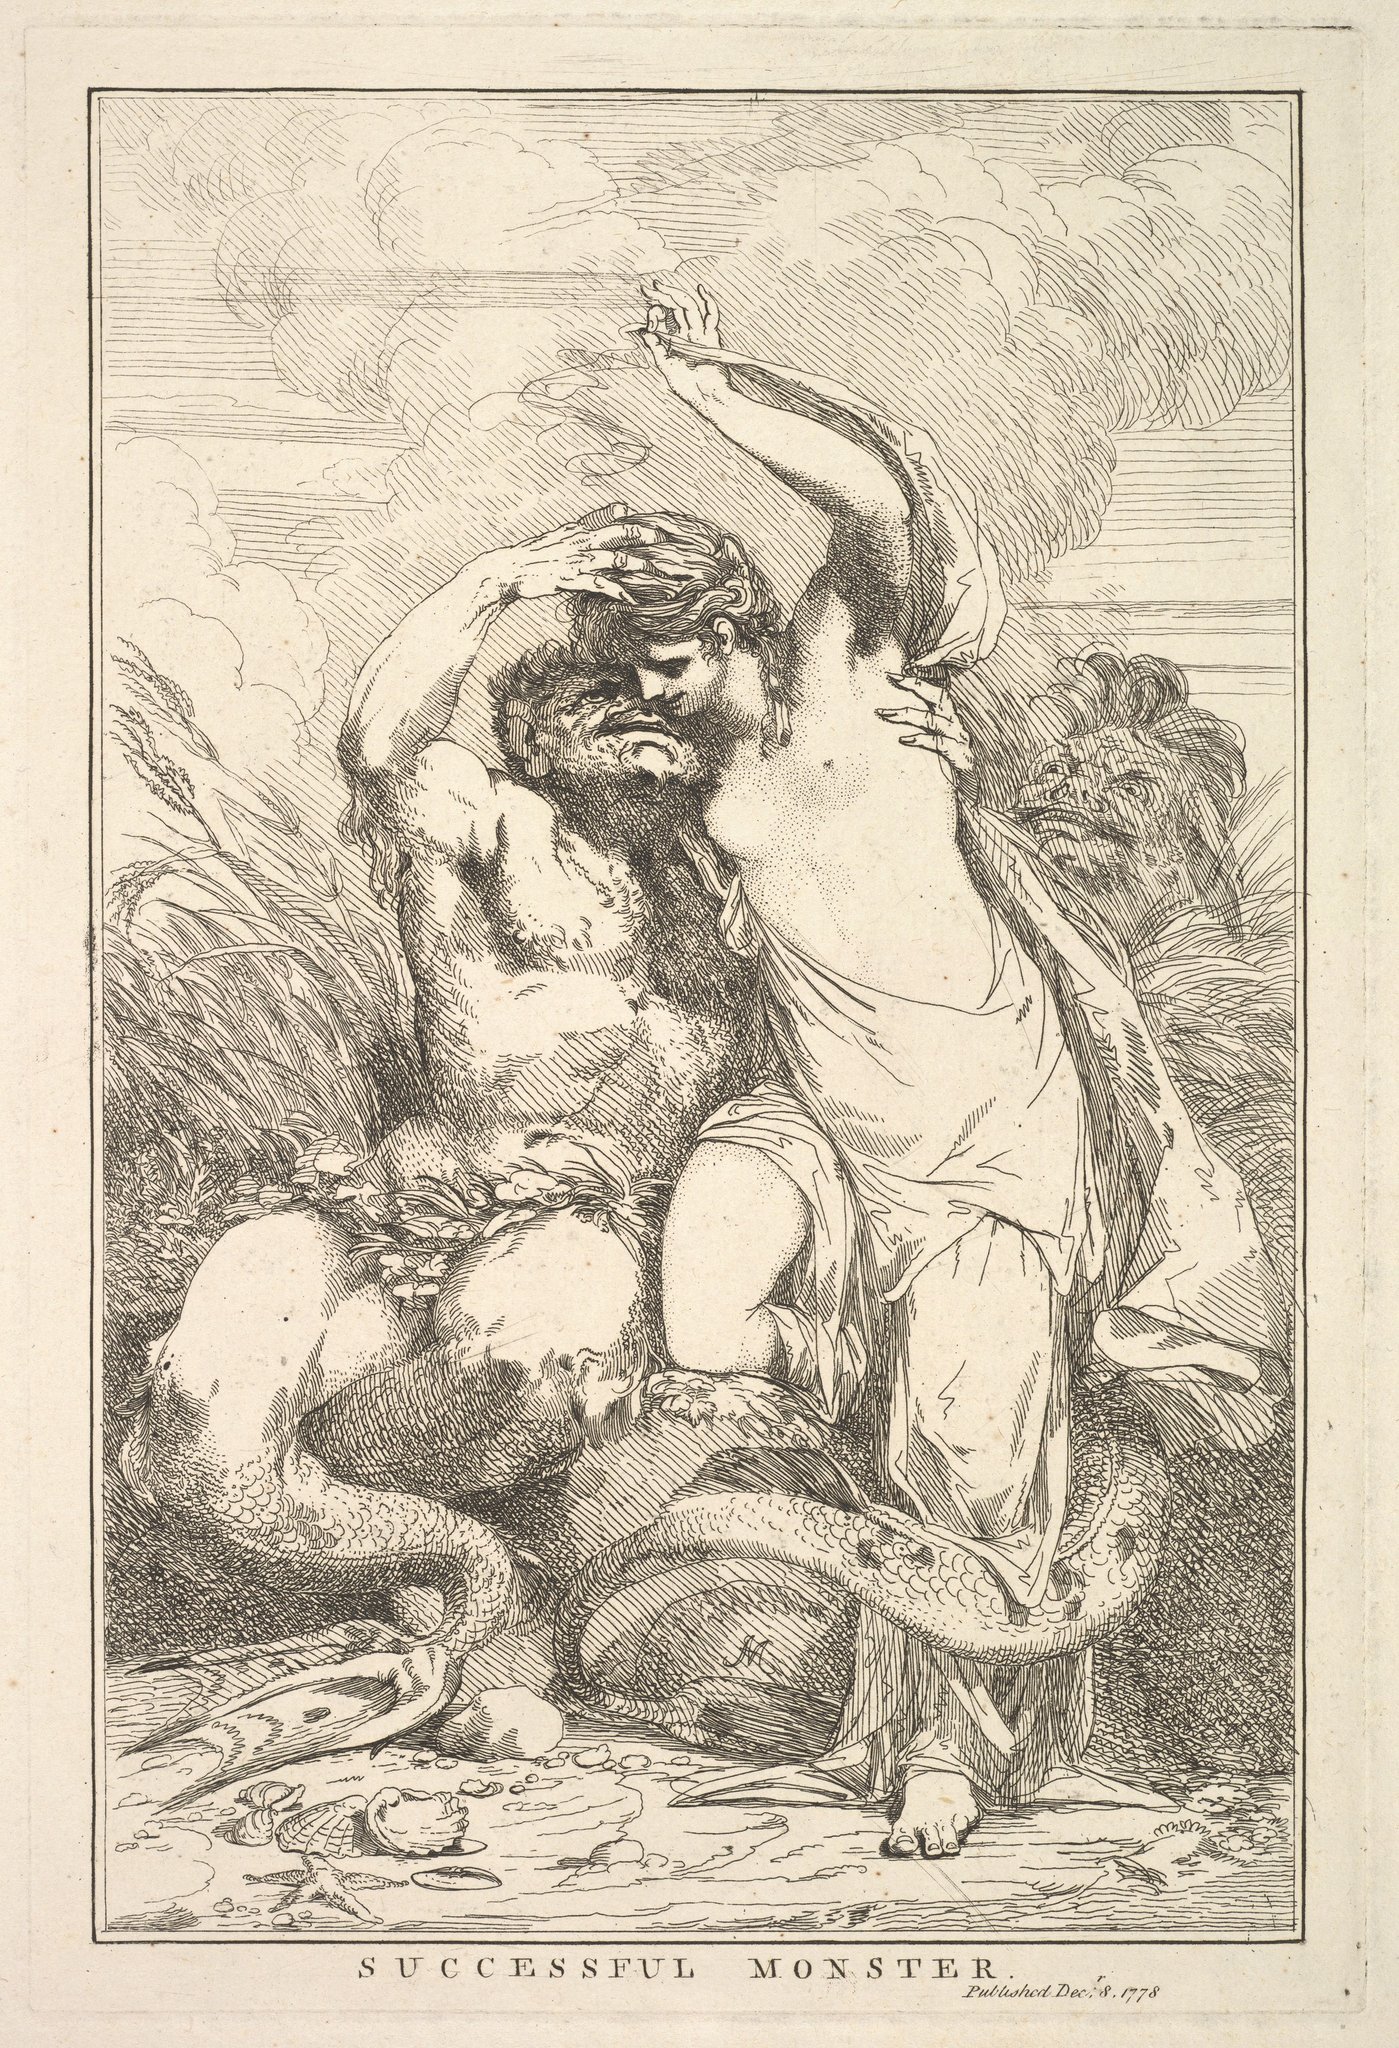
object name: print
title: Successful Monster, from "Fifteen Etchings Dedicated to Sir Joshua Reynolds"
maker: john hamilton mortimer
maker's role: artist and publisher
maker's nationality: british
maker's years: 1740-1779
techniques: etching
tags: female nudes,monsters